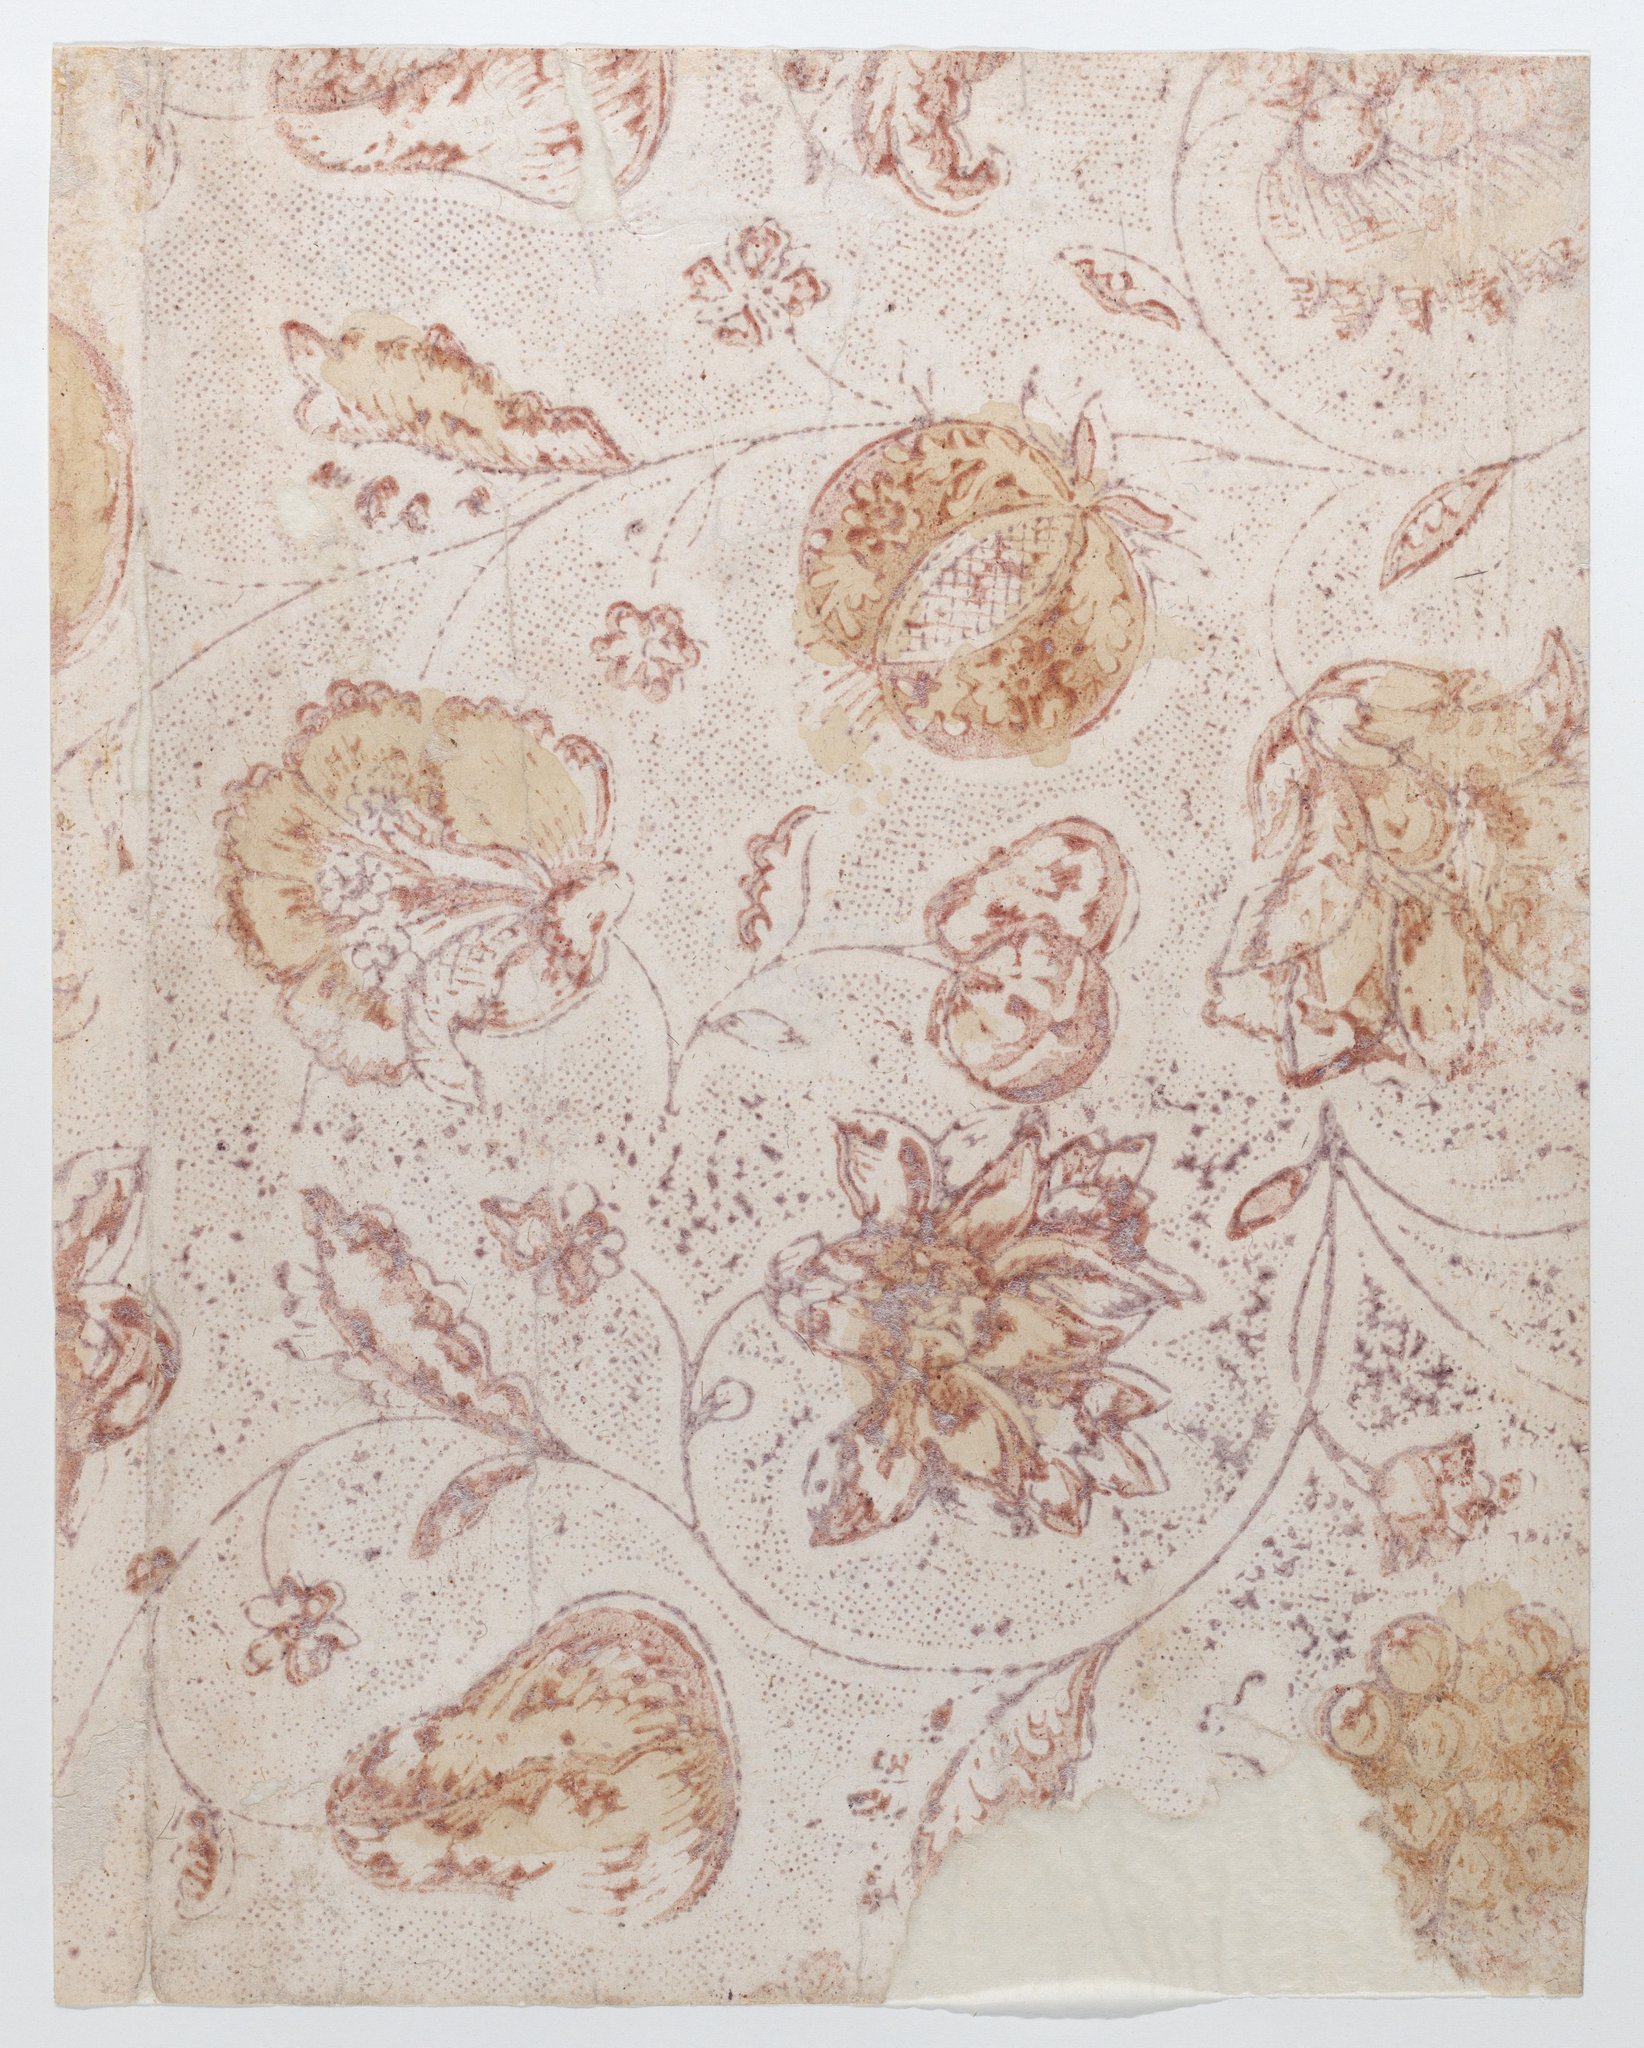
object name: print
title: Sheet with overall floral, fruit, and dot pattern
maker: Anonymous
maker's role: artist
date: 1801-1900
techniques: relief print